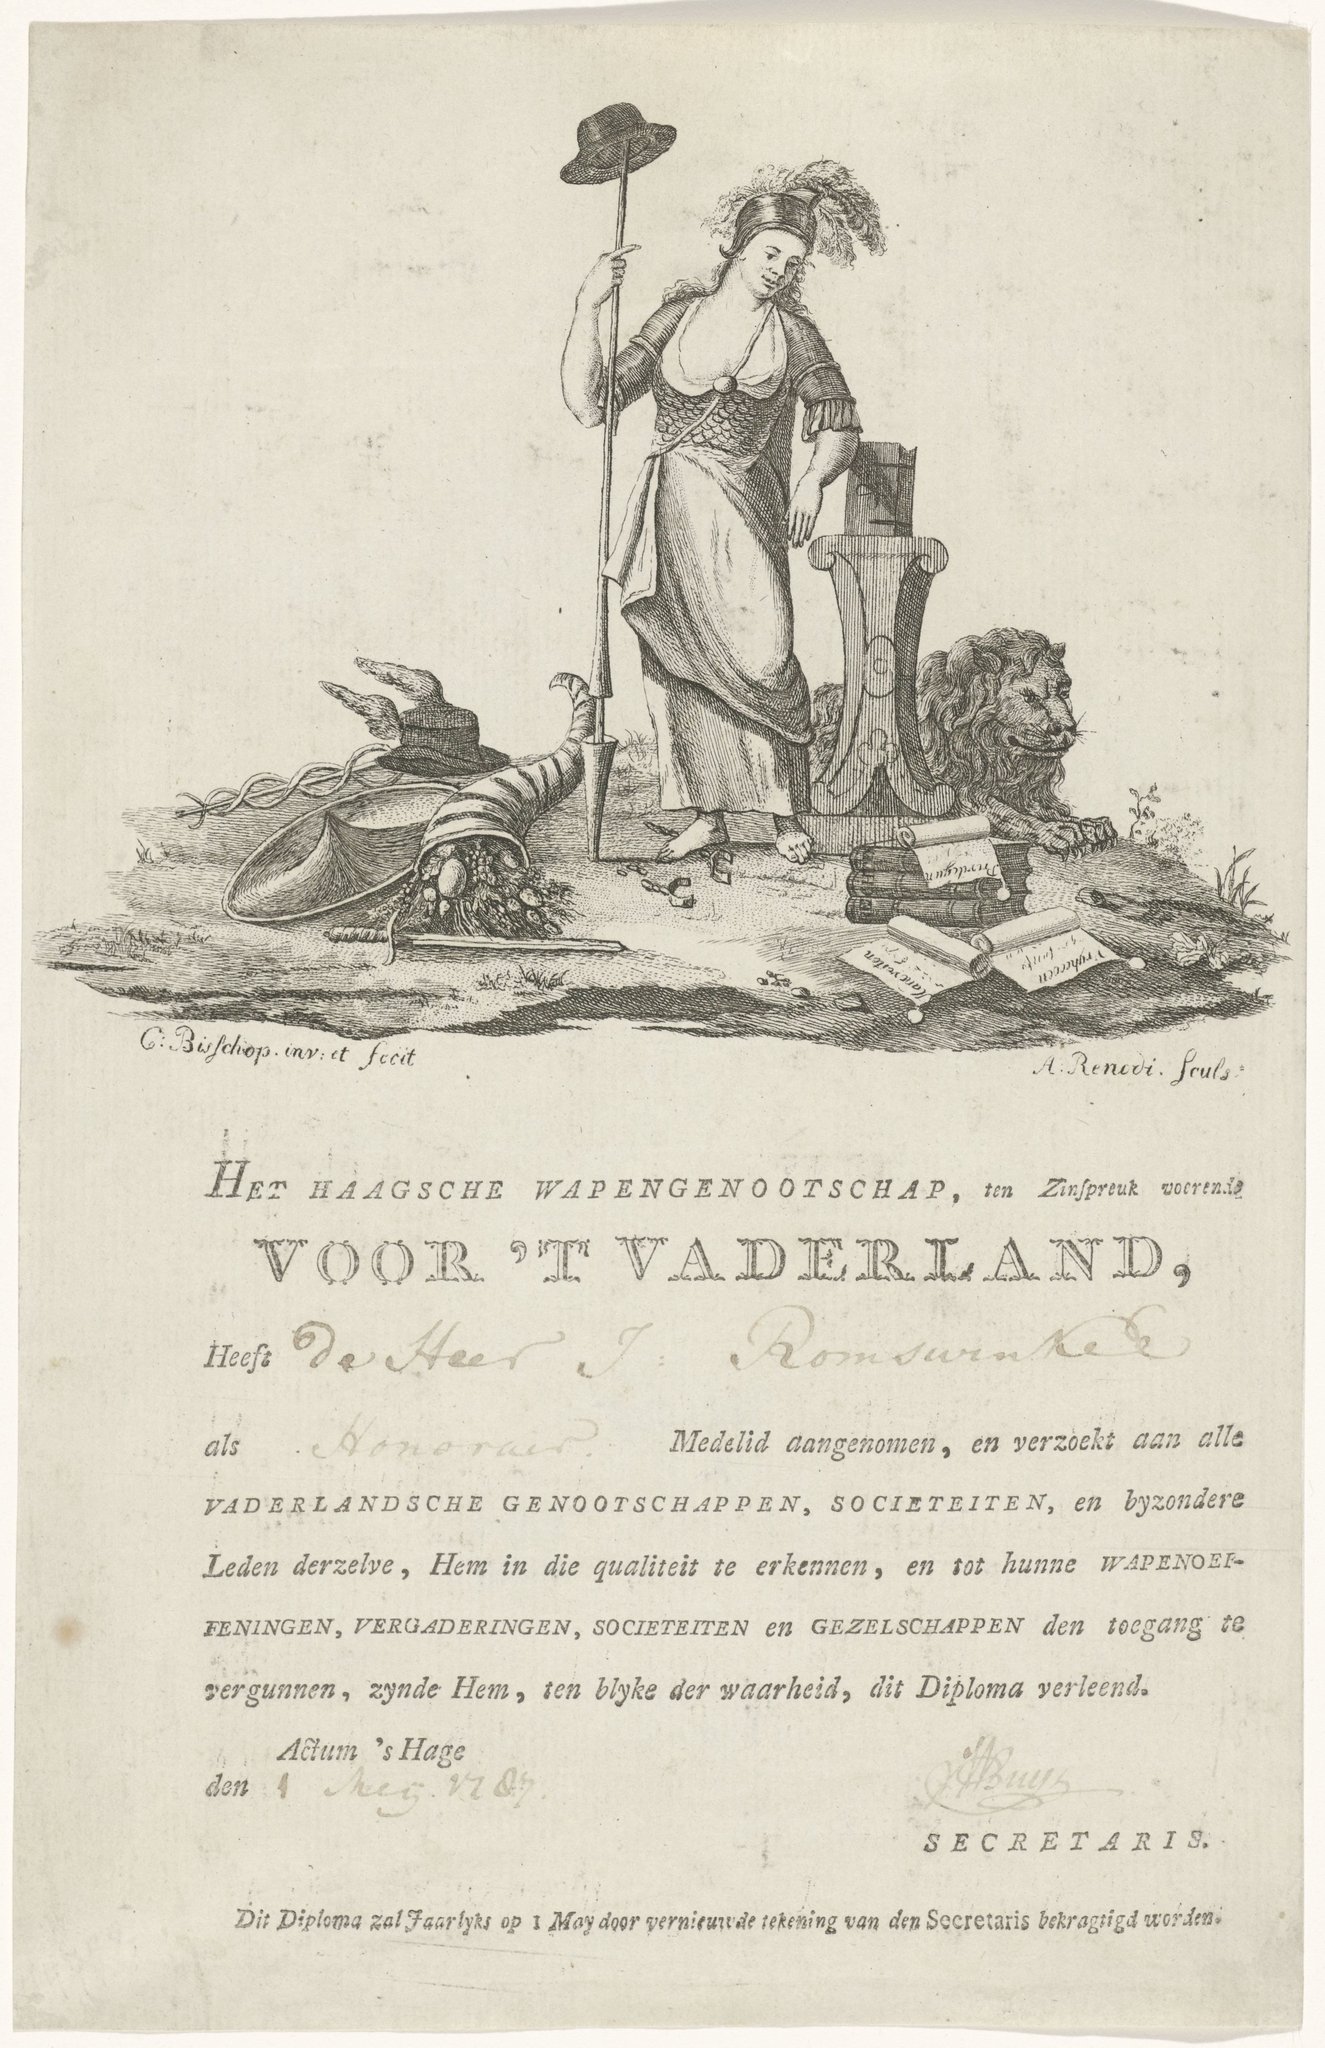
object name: print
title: Diploma van het "Haagsche Wapengenootschap Voor het Vaderland"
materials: paper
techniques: etching, letterpress printing, pen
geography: northern netherlands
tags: 'cornucopia', horn of plenty, freedom, liberty; 'libertà' (ripa)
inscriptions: collector's mark: Lugt 2760, collector's mark: Lugt 2166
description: Boven de tekst een afbeelding van de personificatie van Vrijheid, met in de hand de vrijheidslans met de vrijheidshoed. Achter haar ligt de Hollandse leeuw en voor haar voeten ligt een stapel boeken waar 'recht' op staat. Links een zwaard, de hoorn des overvloeds en de mercuriusstaf en hoed.